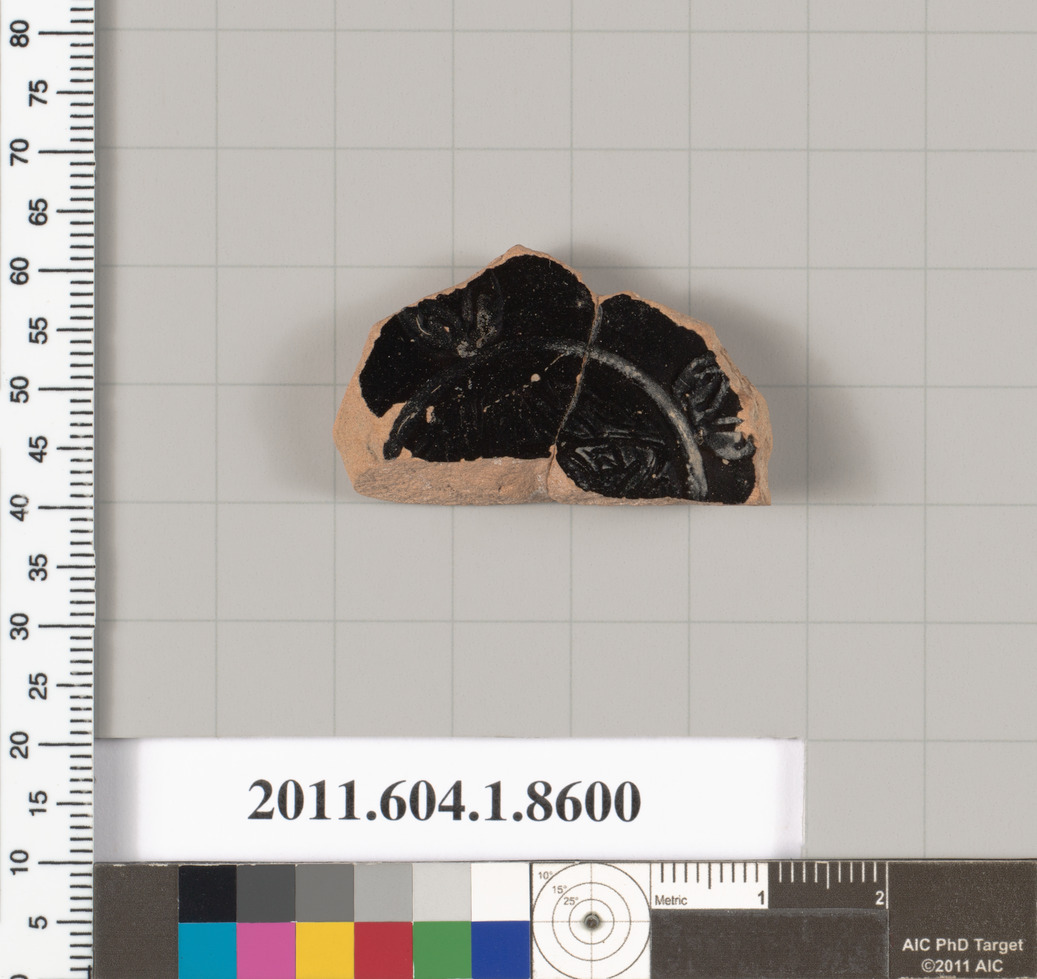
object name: kylix fragment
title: Terracotta fragment of a stemless kylix (drinking cup)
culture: greek, attic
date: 434-401 BCE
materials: terracotta